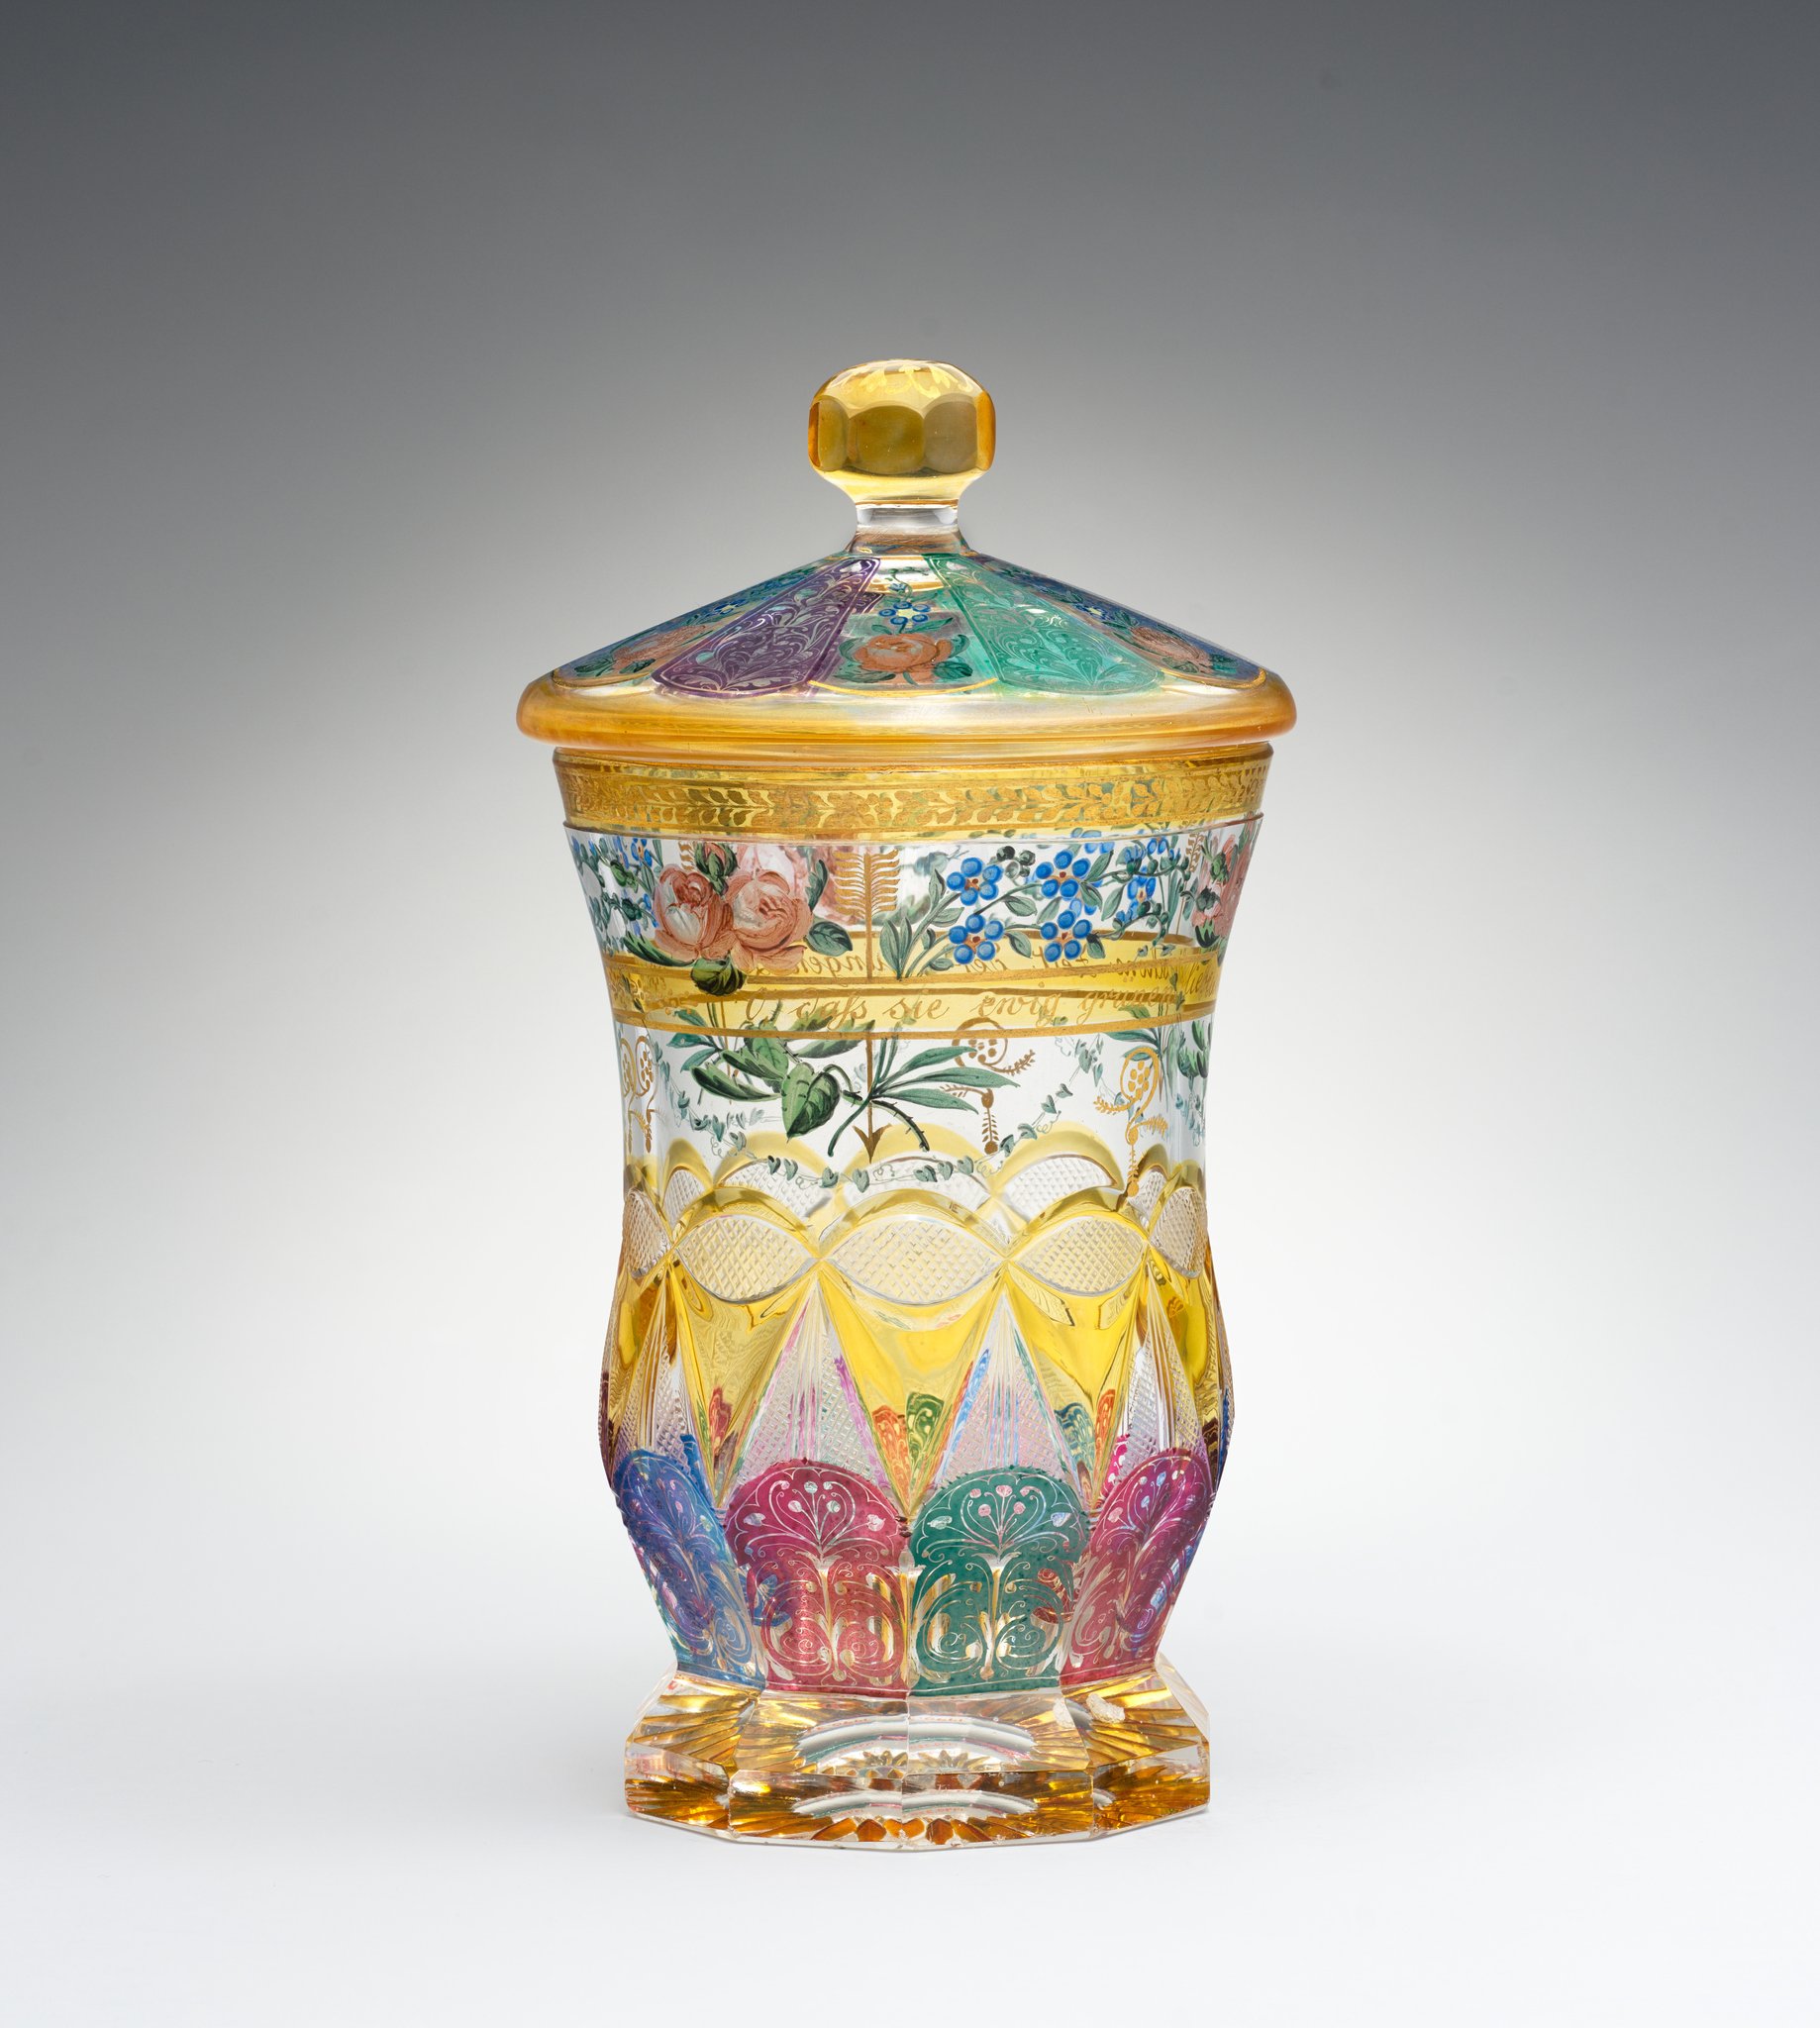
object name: beaker with cover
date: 1850-1860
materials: glass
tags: flowers